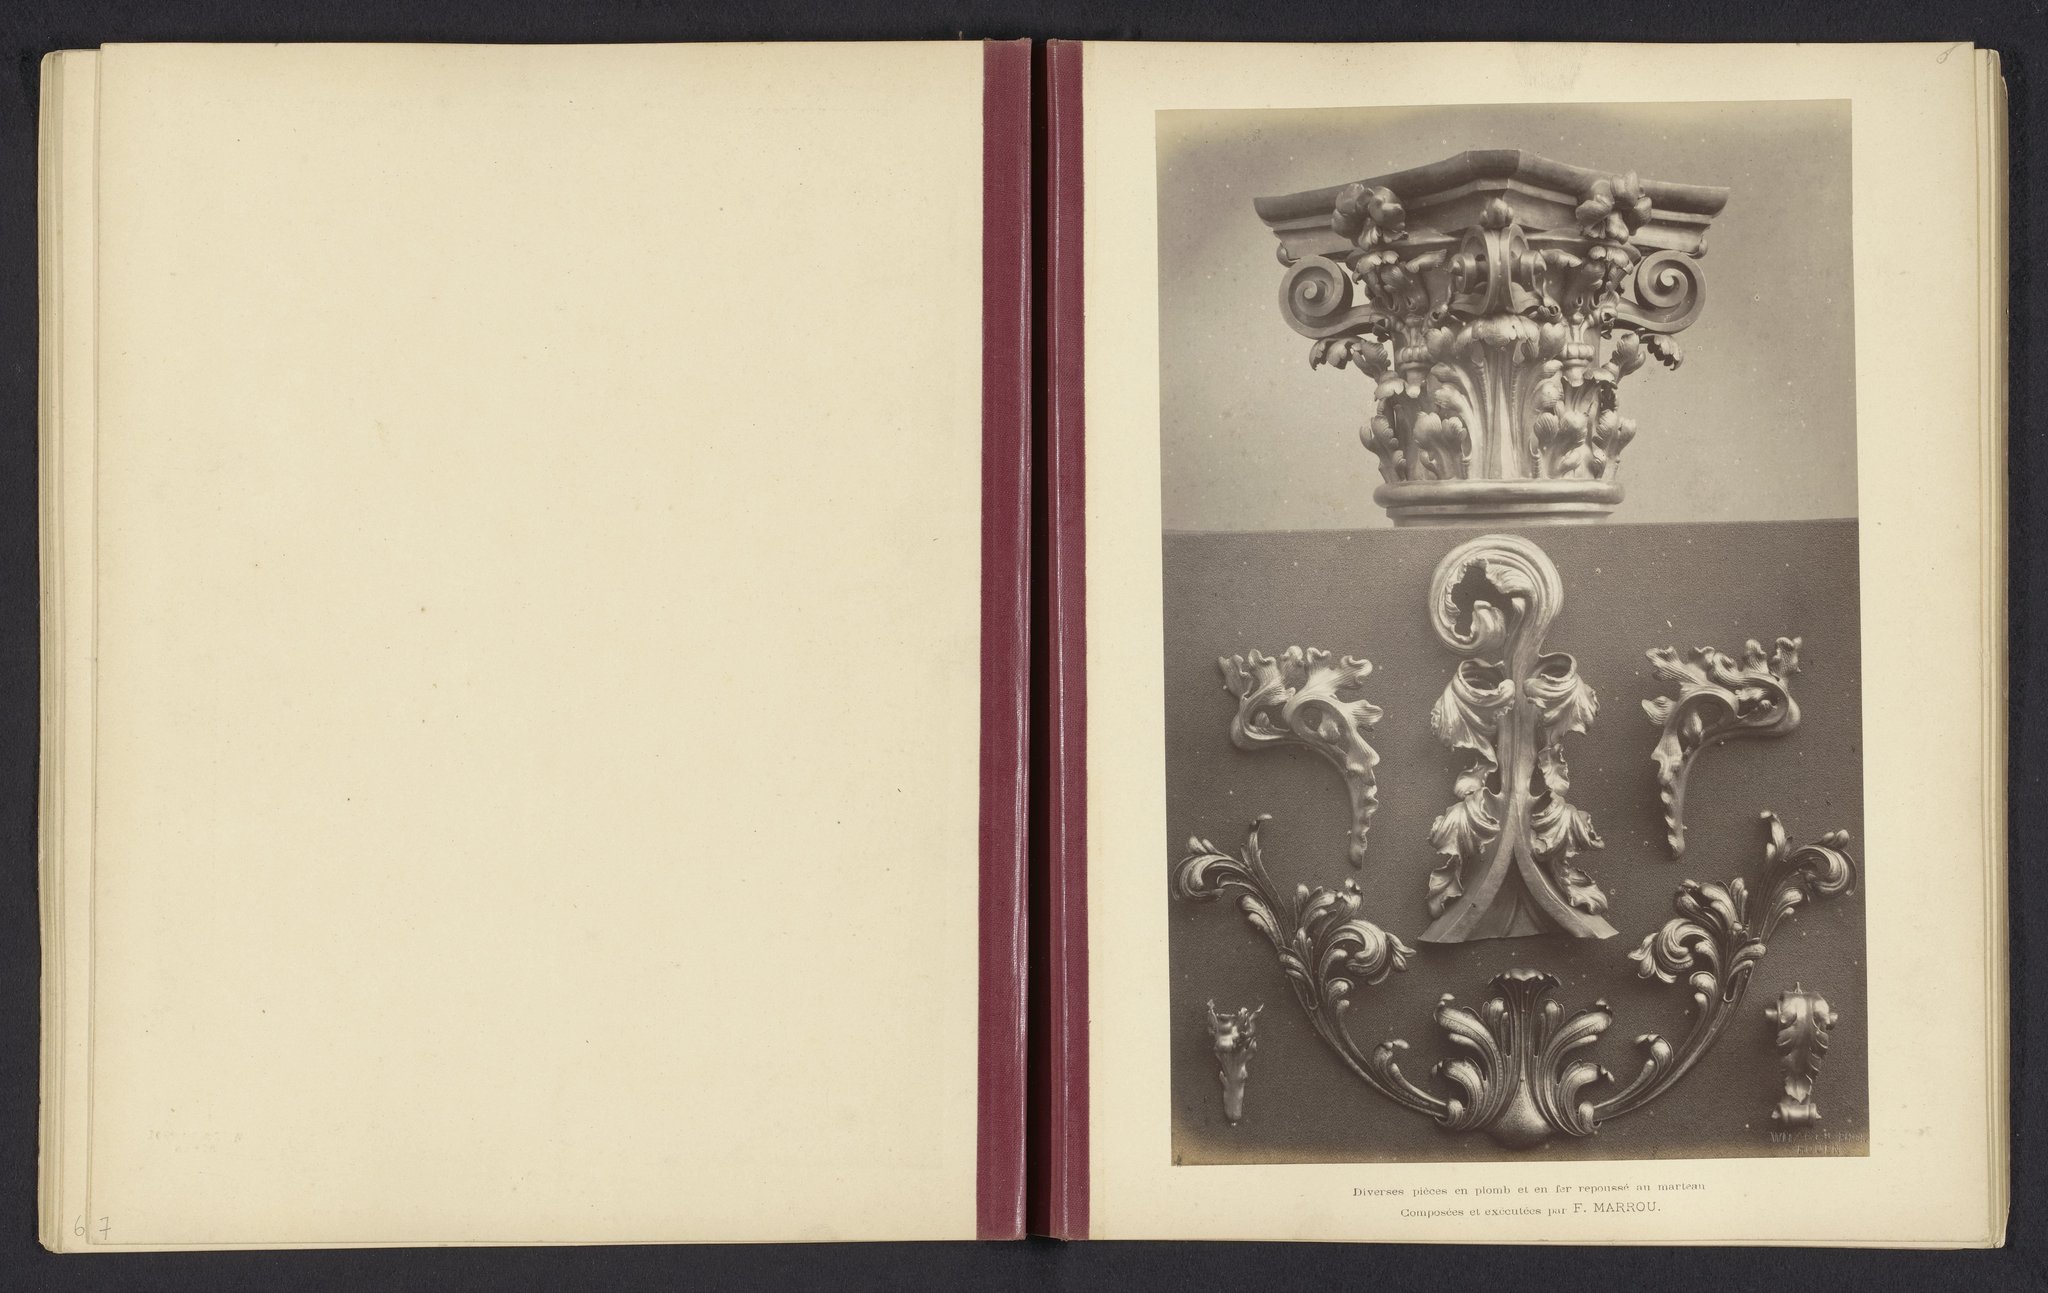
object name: page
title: Diverses pièces en plomb et en fer repoussé au martean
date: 1874-1884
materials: photographic support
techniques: albumen print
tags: capital (~ column, pillar), ornament derived from plant forms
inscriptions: inscription: ‘Composées et exécutées par F. Marrou.’, name: ‘Witz & cie Phot. Rouen’